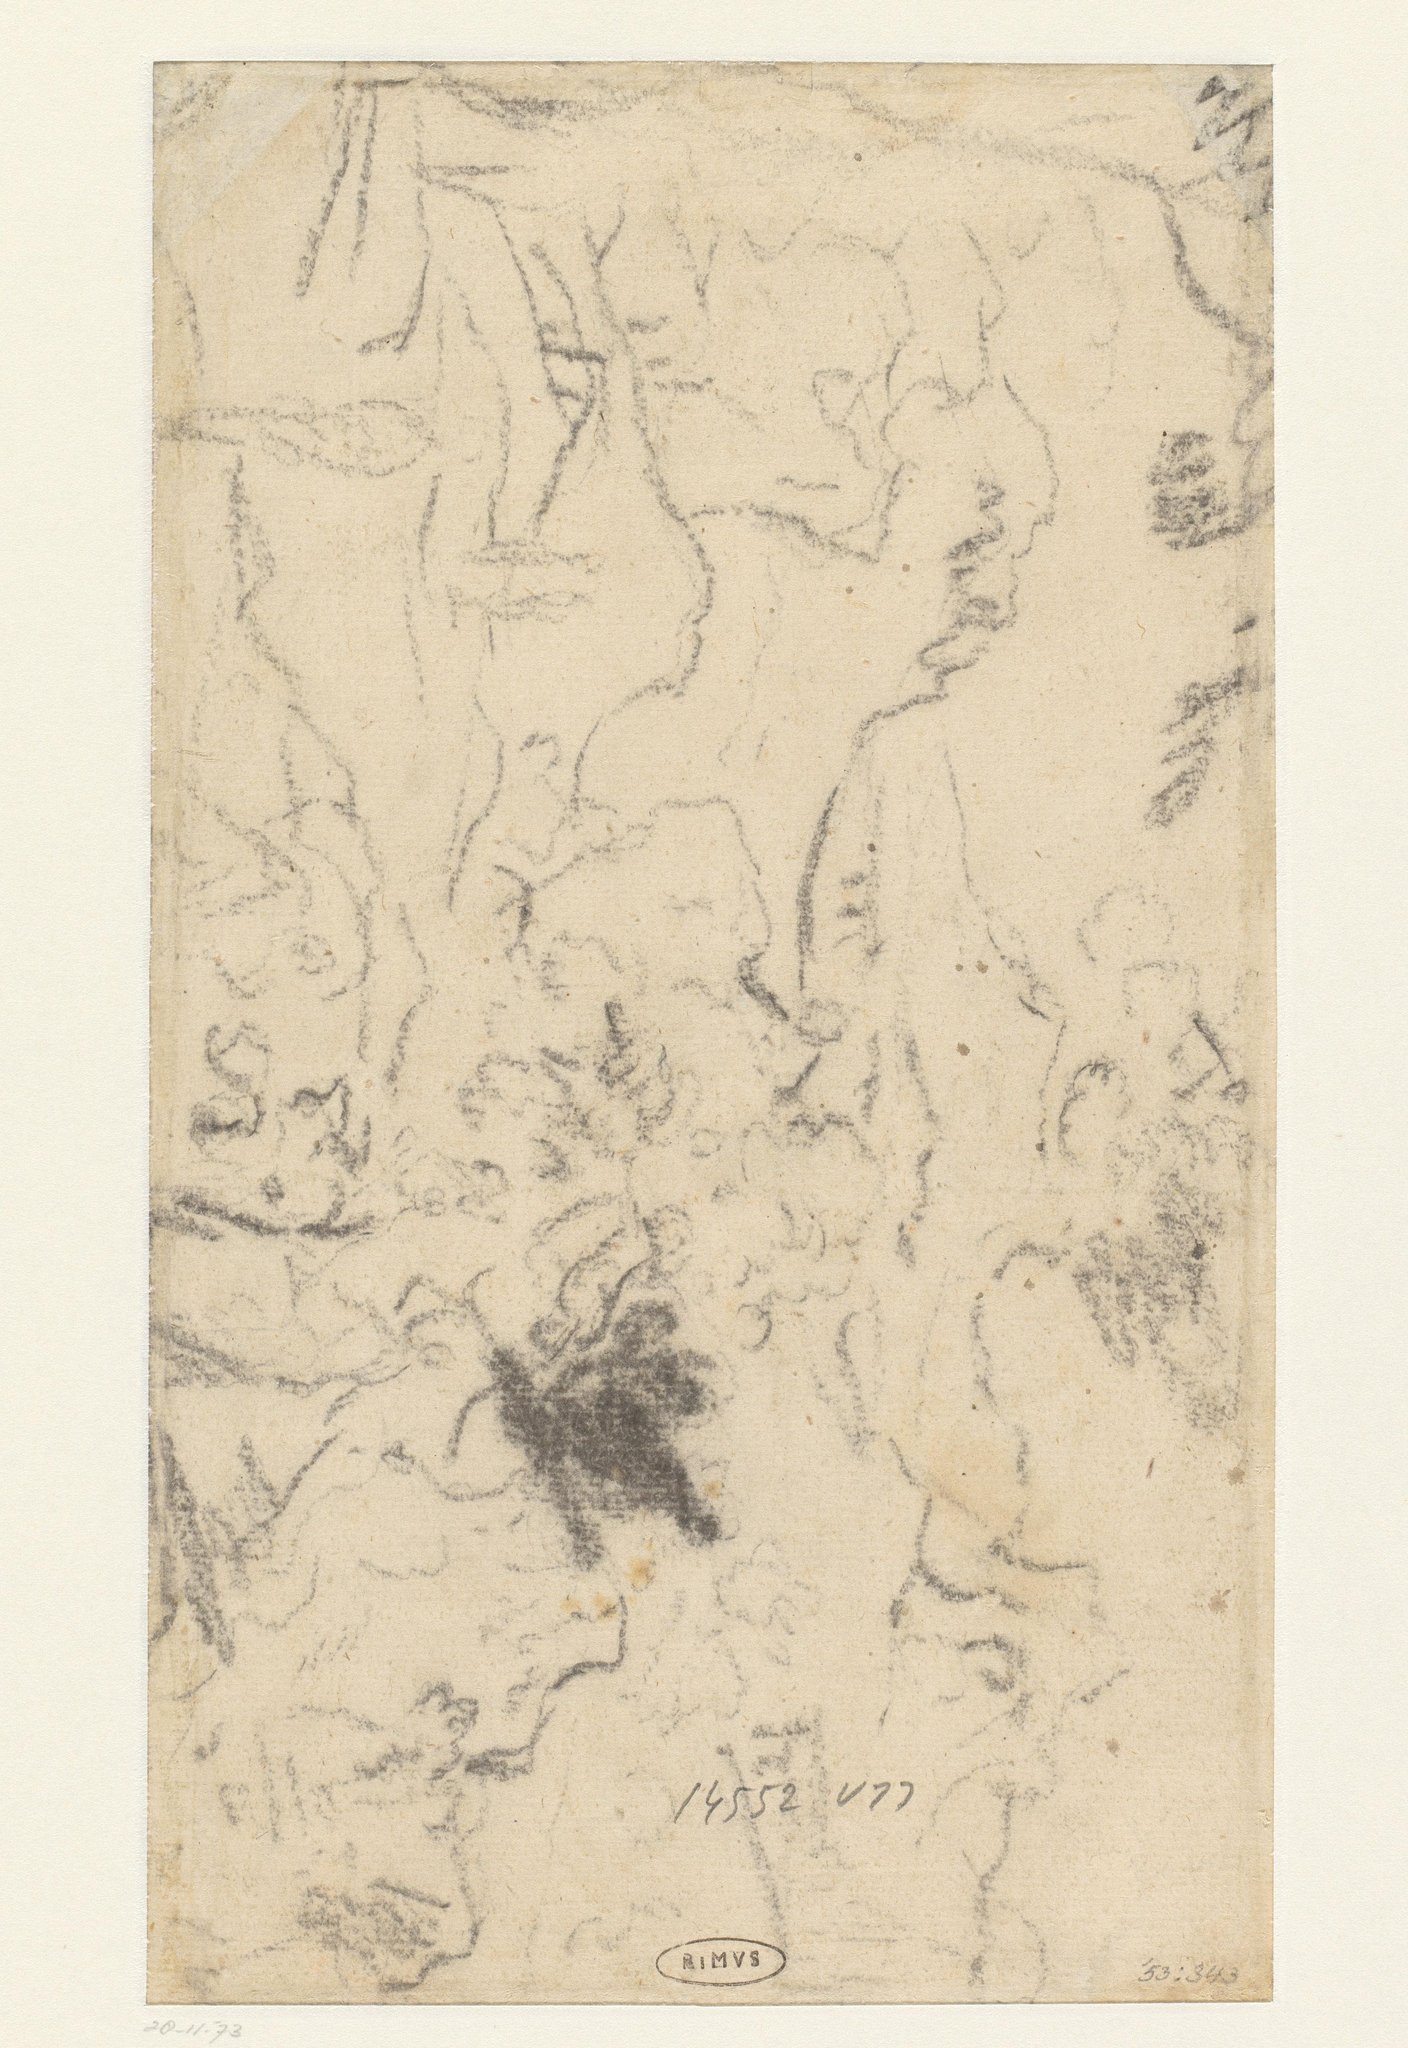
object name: drawing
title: Heuvelachtig landschap met enkele figuren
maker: lancelot blondeel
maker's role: draughtsman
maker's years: 1498-1561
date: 1543-1556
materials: charcoal, paper